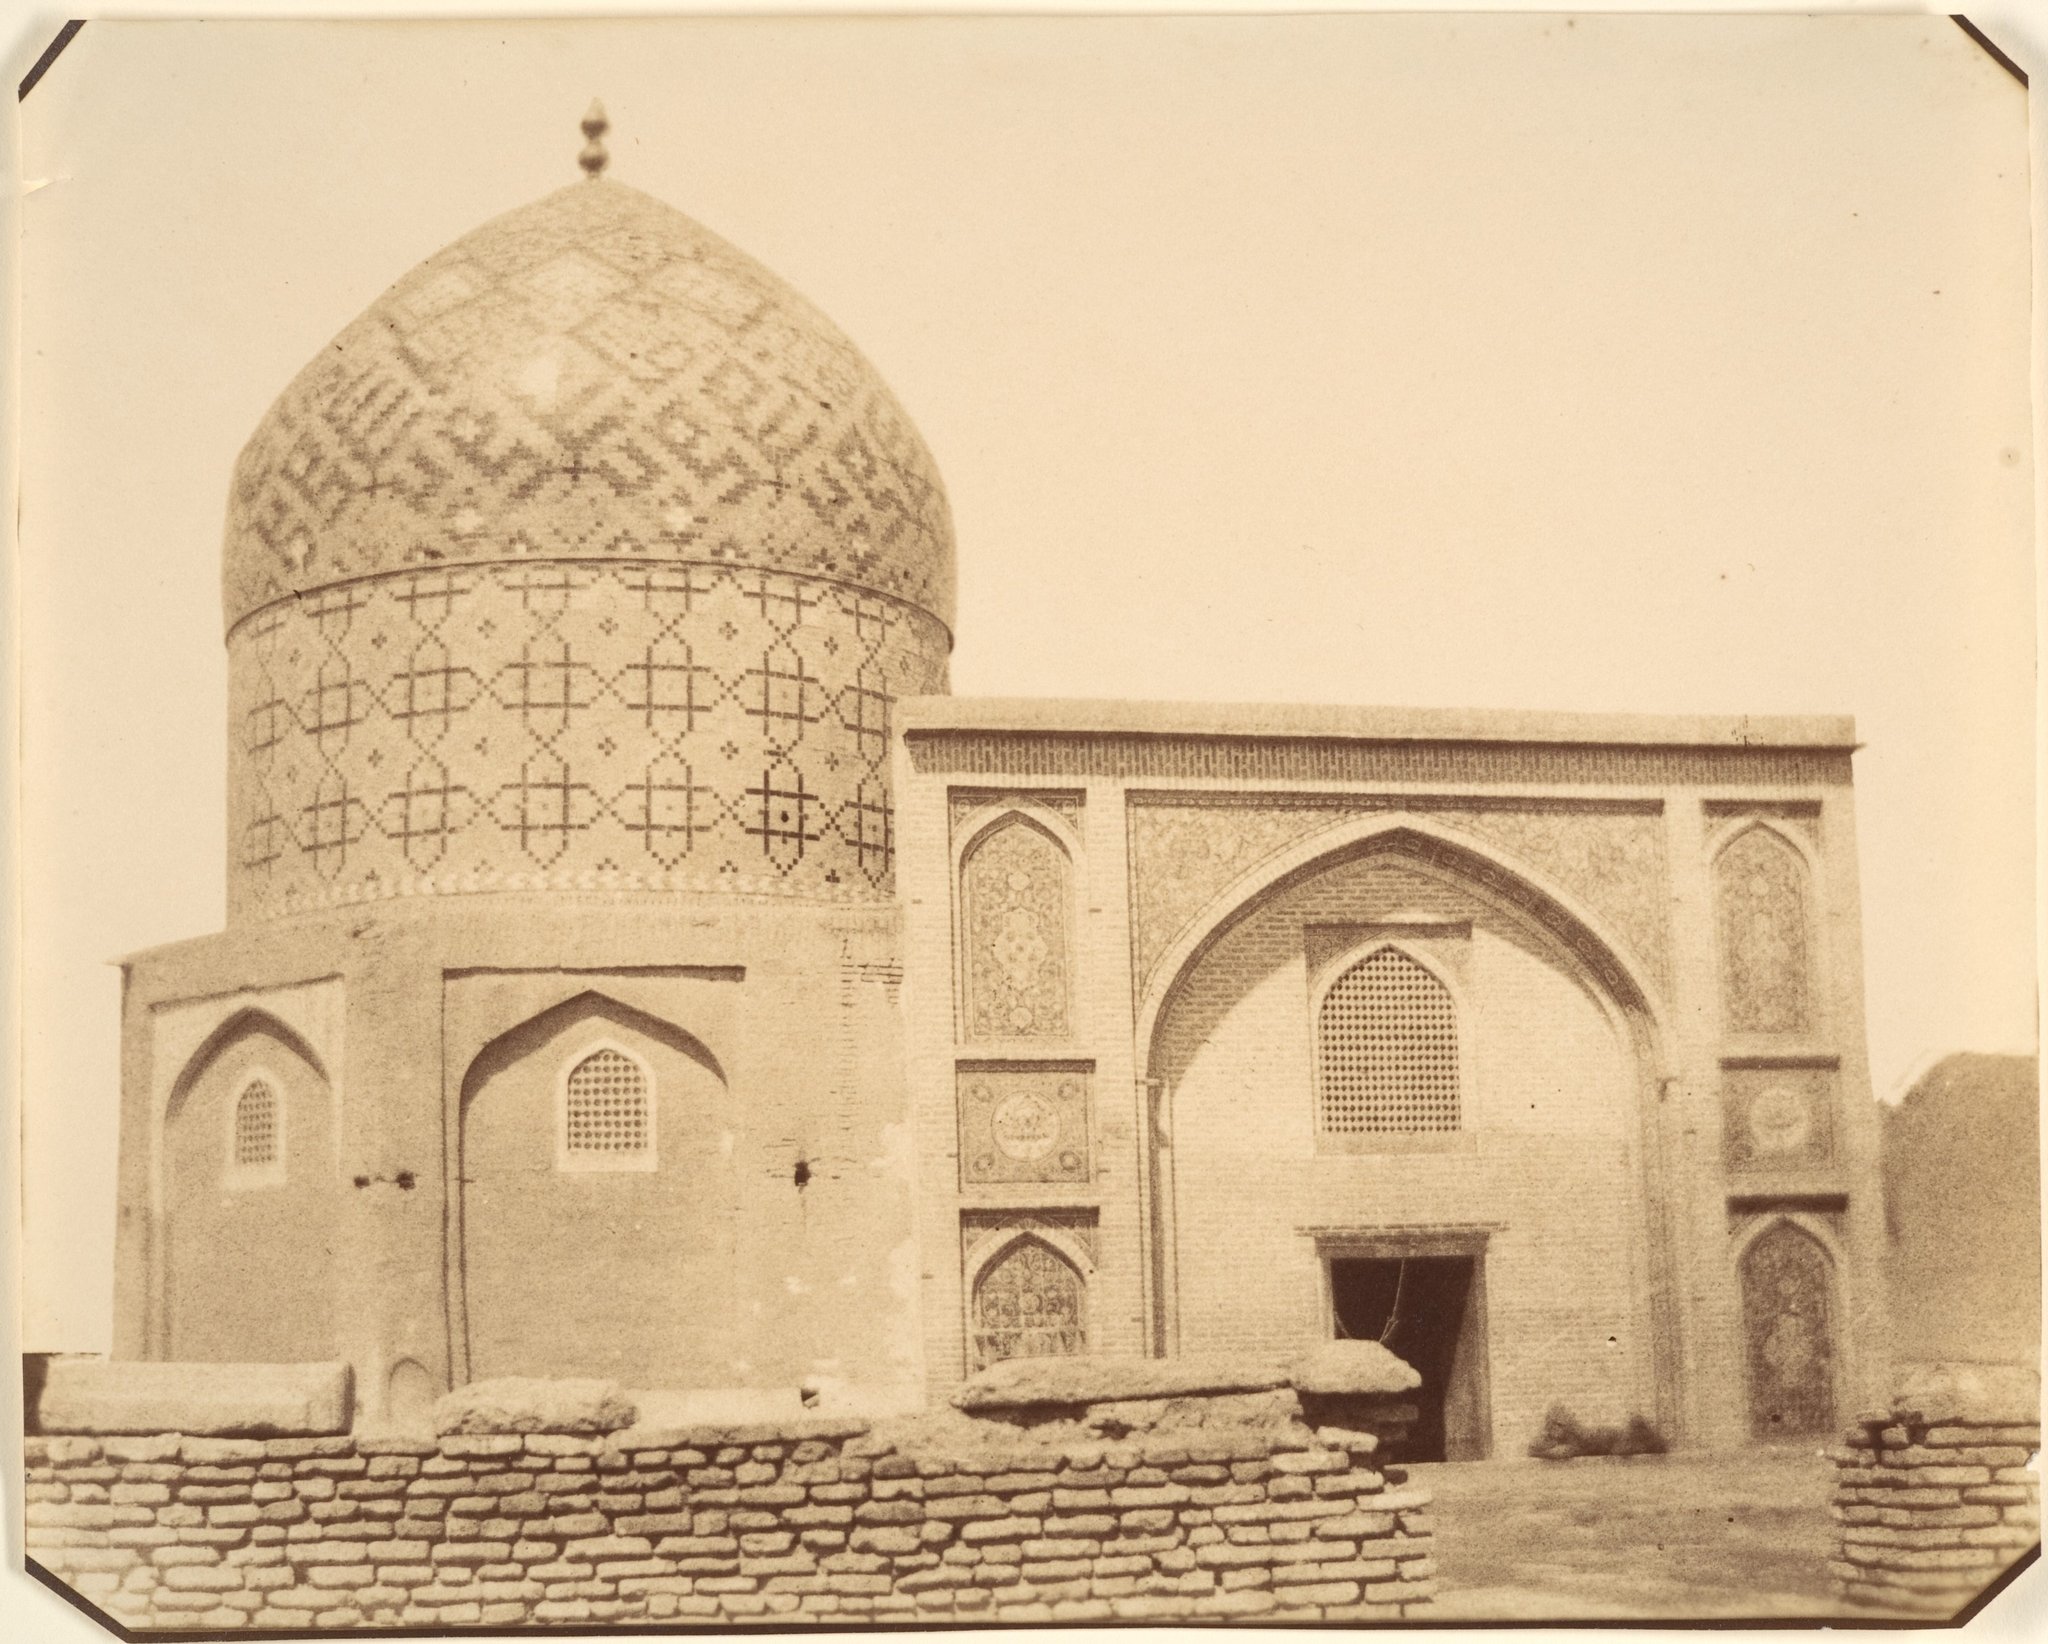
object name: photograph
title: [Mosque of Nasser-eddin Shah, Teheran, Iran]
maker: luigi pesce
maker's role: artist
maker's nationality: italian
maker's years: 1818-1891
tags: architecture,mosques